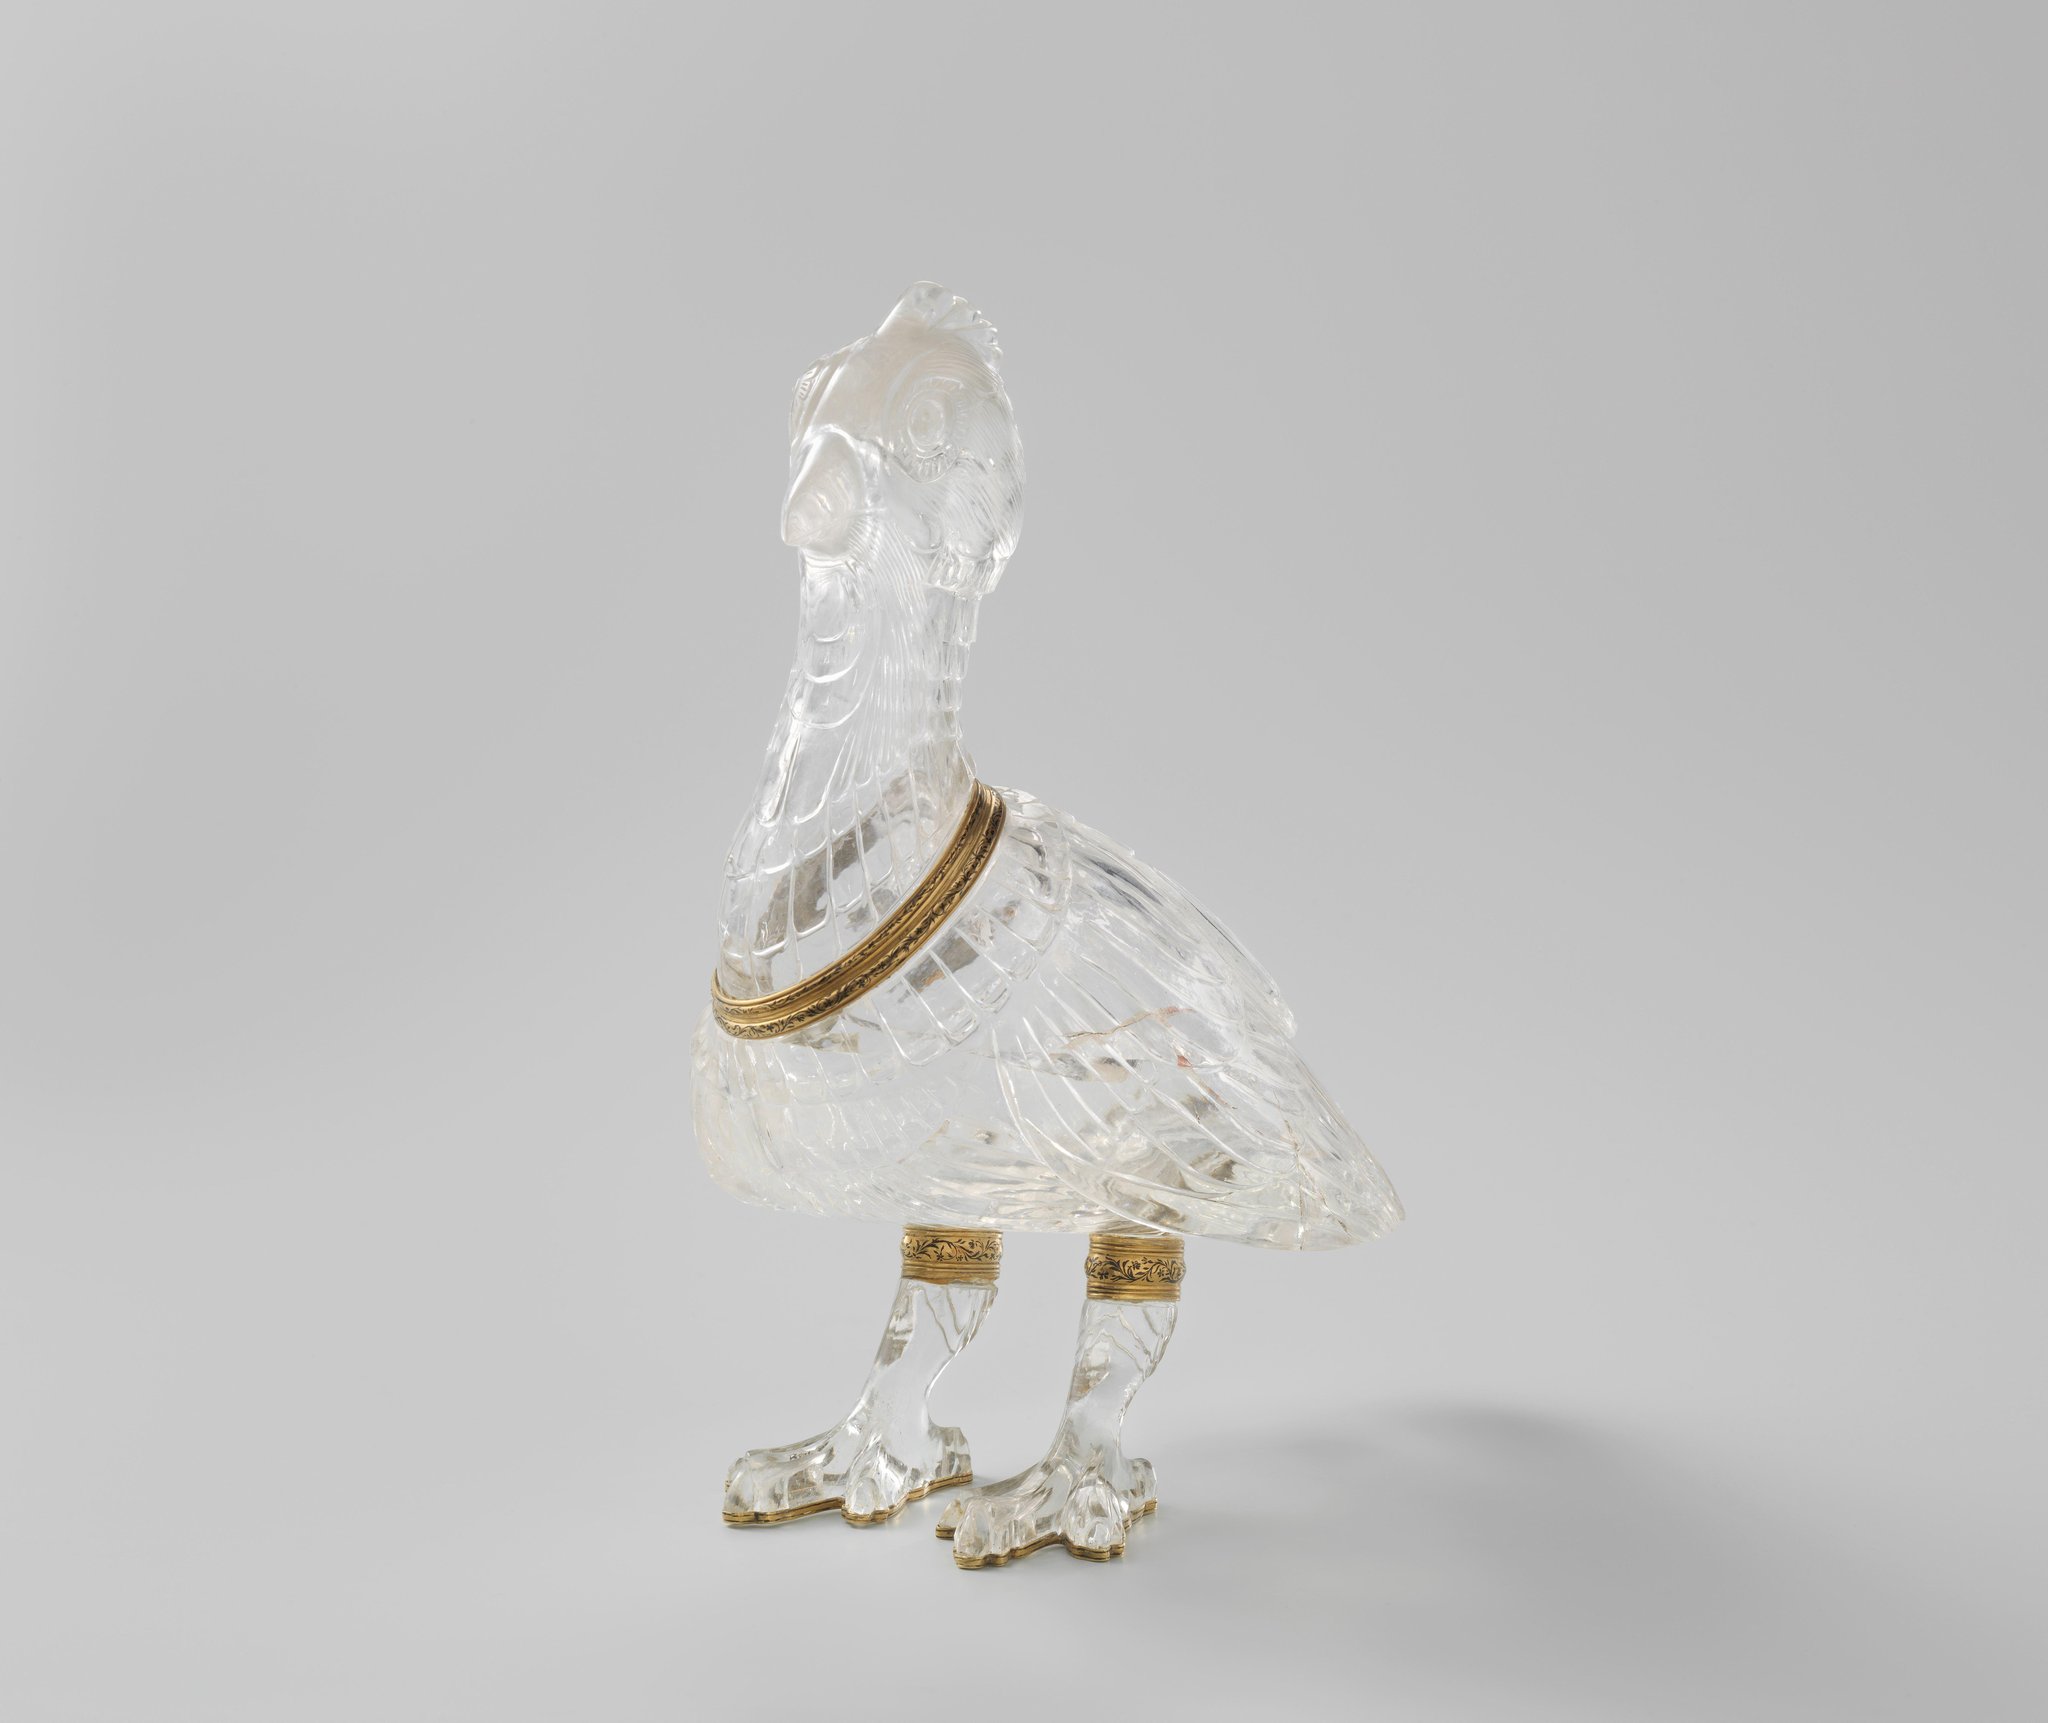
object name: figure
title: Bird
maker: Anonymous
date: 1600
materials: gold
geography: italy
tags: birds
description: Beeld van bergkristal in de vorm van een vogel. Montuur van goud. Op de rug een ovale opening met scharnierend deksel.